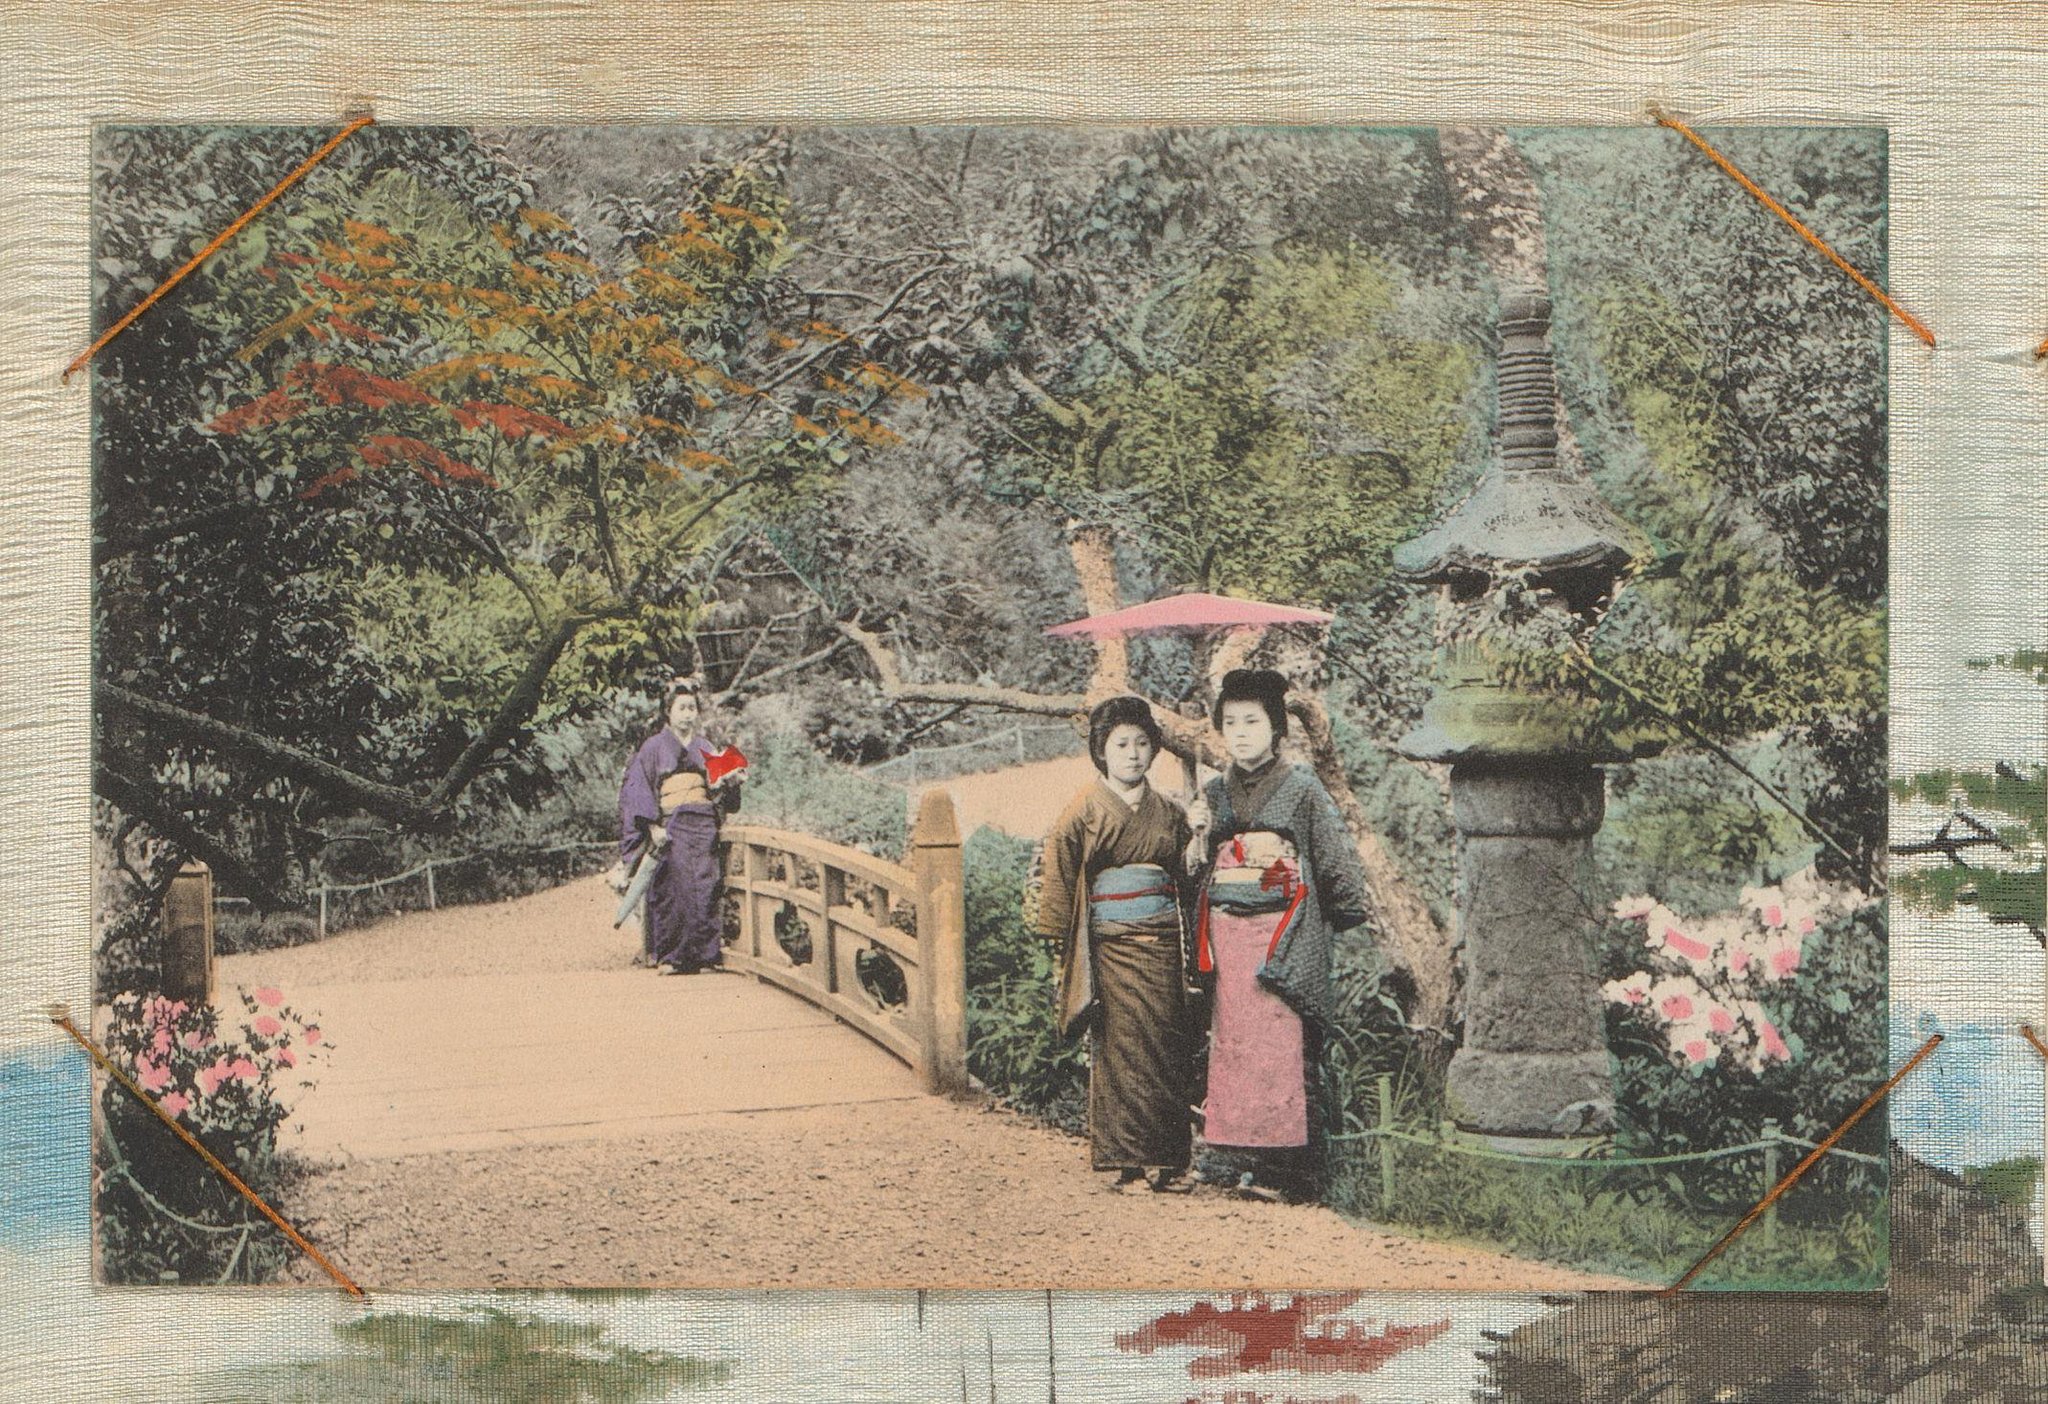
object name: photomechanical print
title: Drie vrouwen in kimono in een tuin, Japan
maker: Anonymous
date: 1900-1920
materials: paper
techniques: photograph, hand coloring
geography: japan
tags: adult woman (+ three persons), folk costume, regional costume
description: Deze prent maakt deel uit van een album.